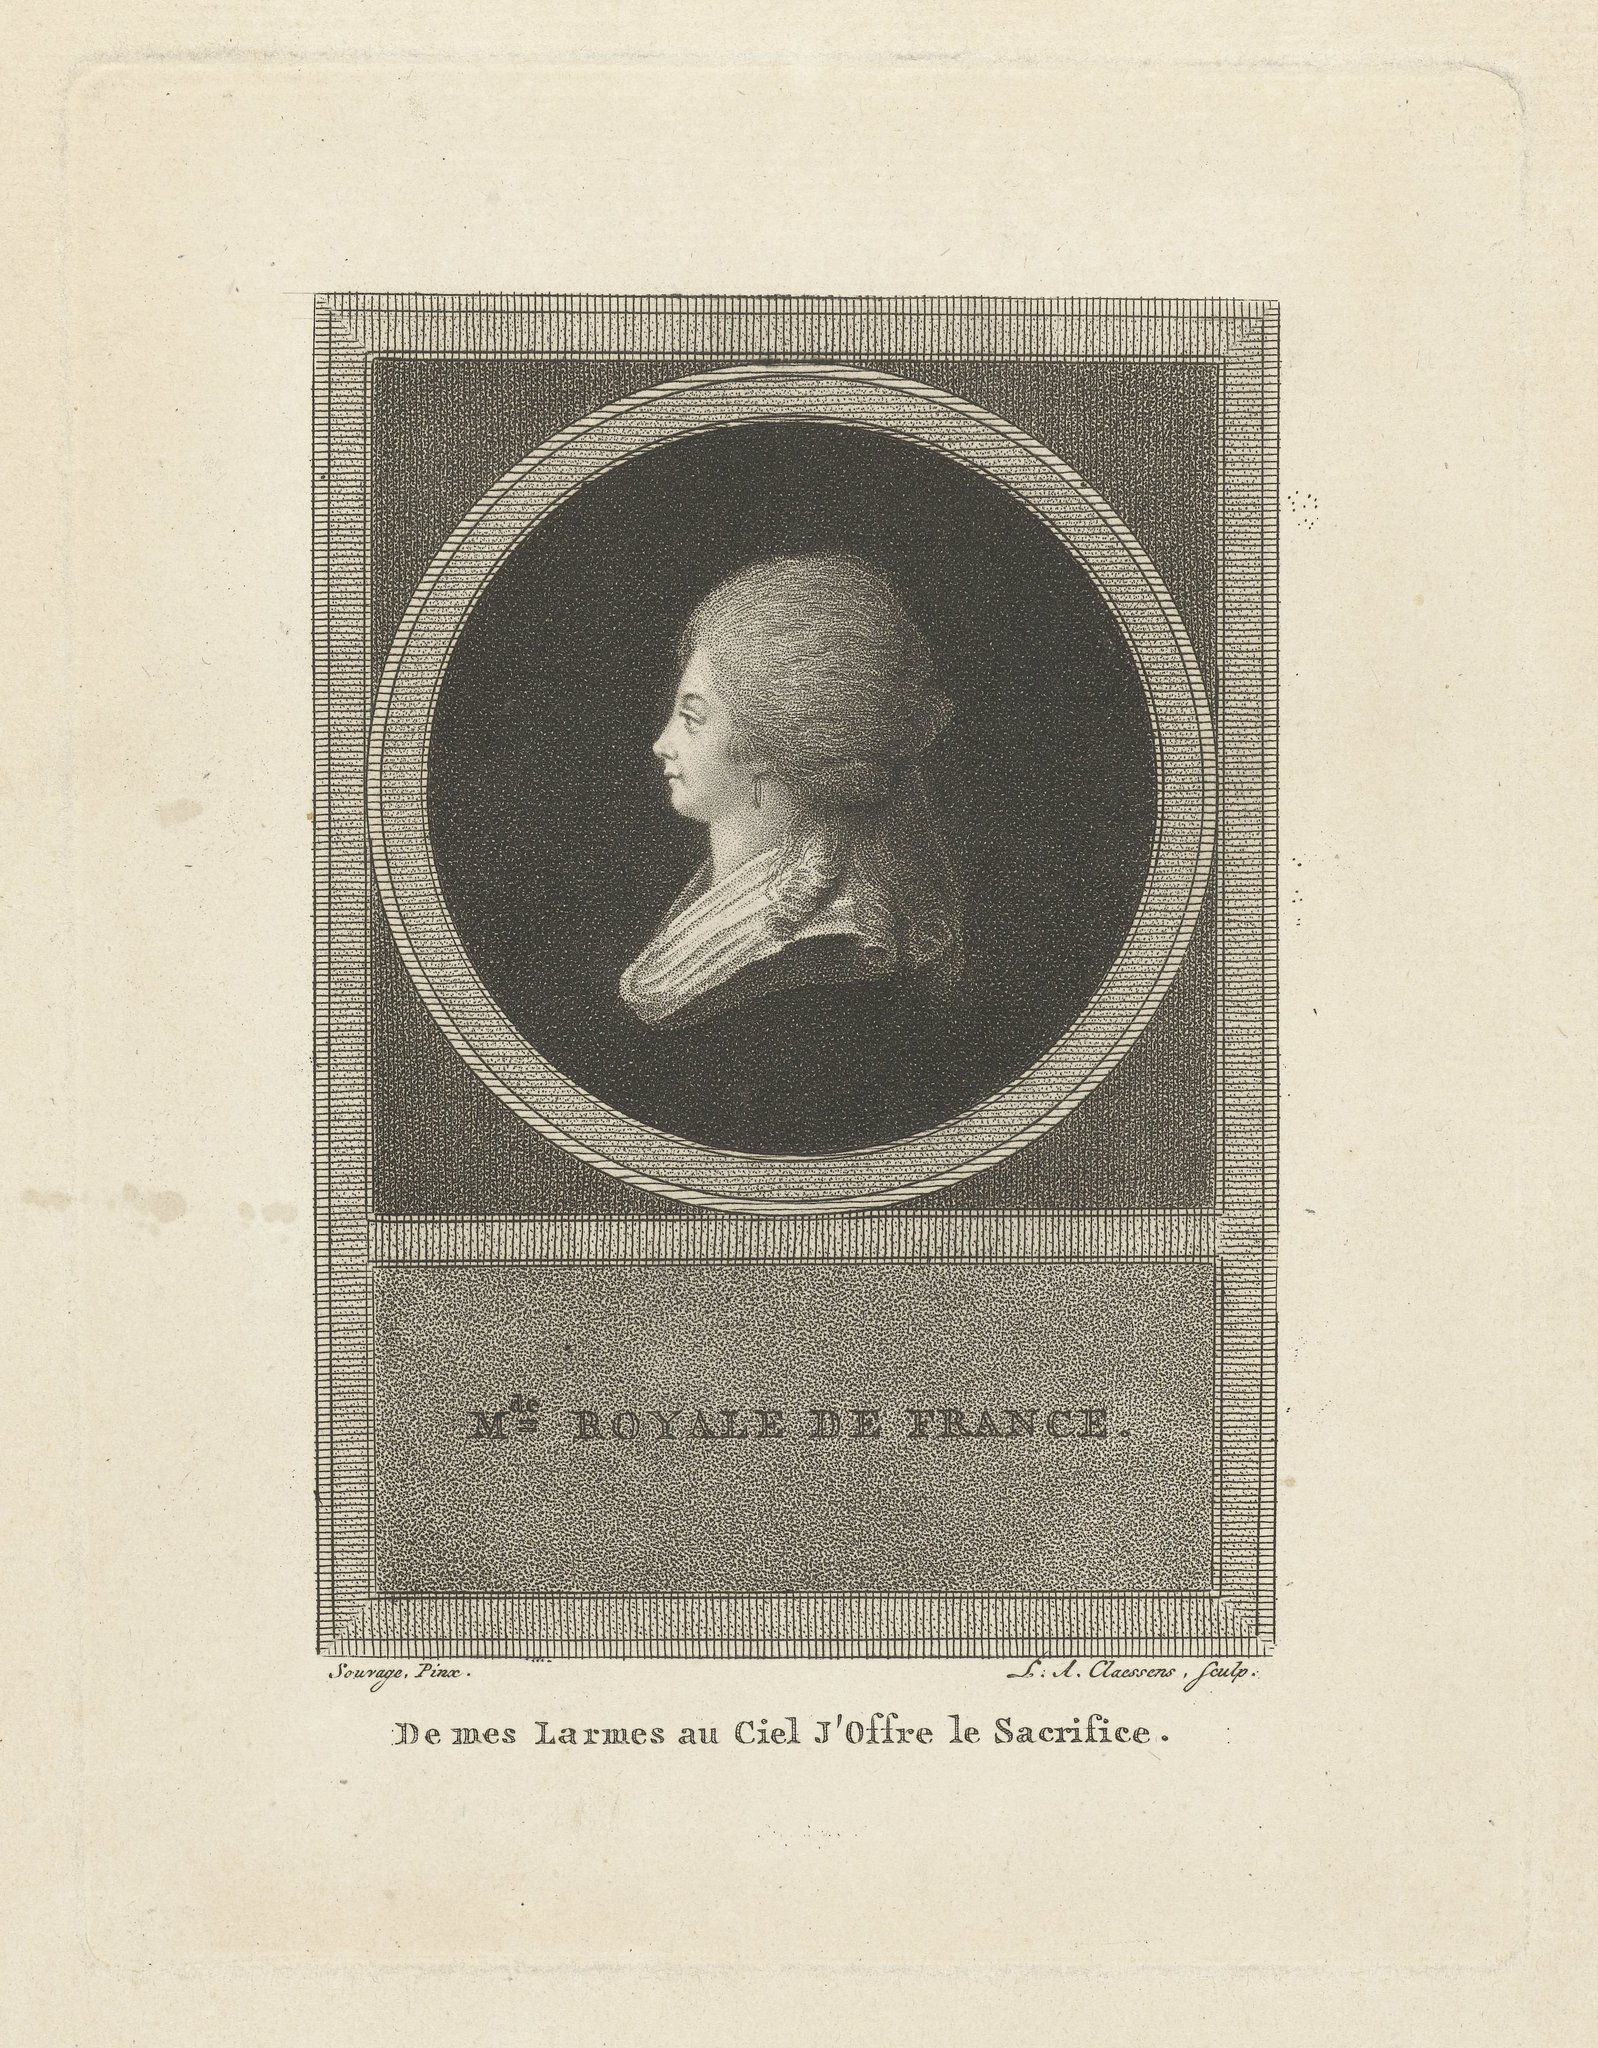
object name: print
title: Portret van Élisabeth Philippine Marie Hélène de France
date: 1794-1834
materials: paper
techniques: engraving, etching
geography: amsterdam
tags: élisabeth philippine marie hélène de france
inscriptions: collector's mark: Lugt 2228